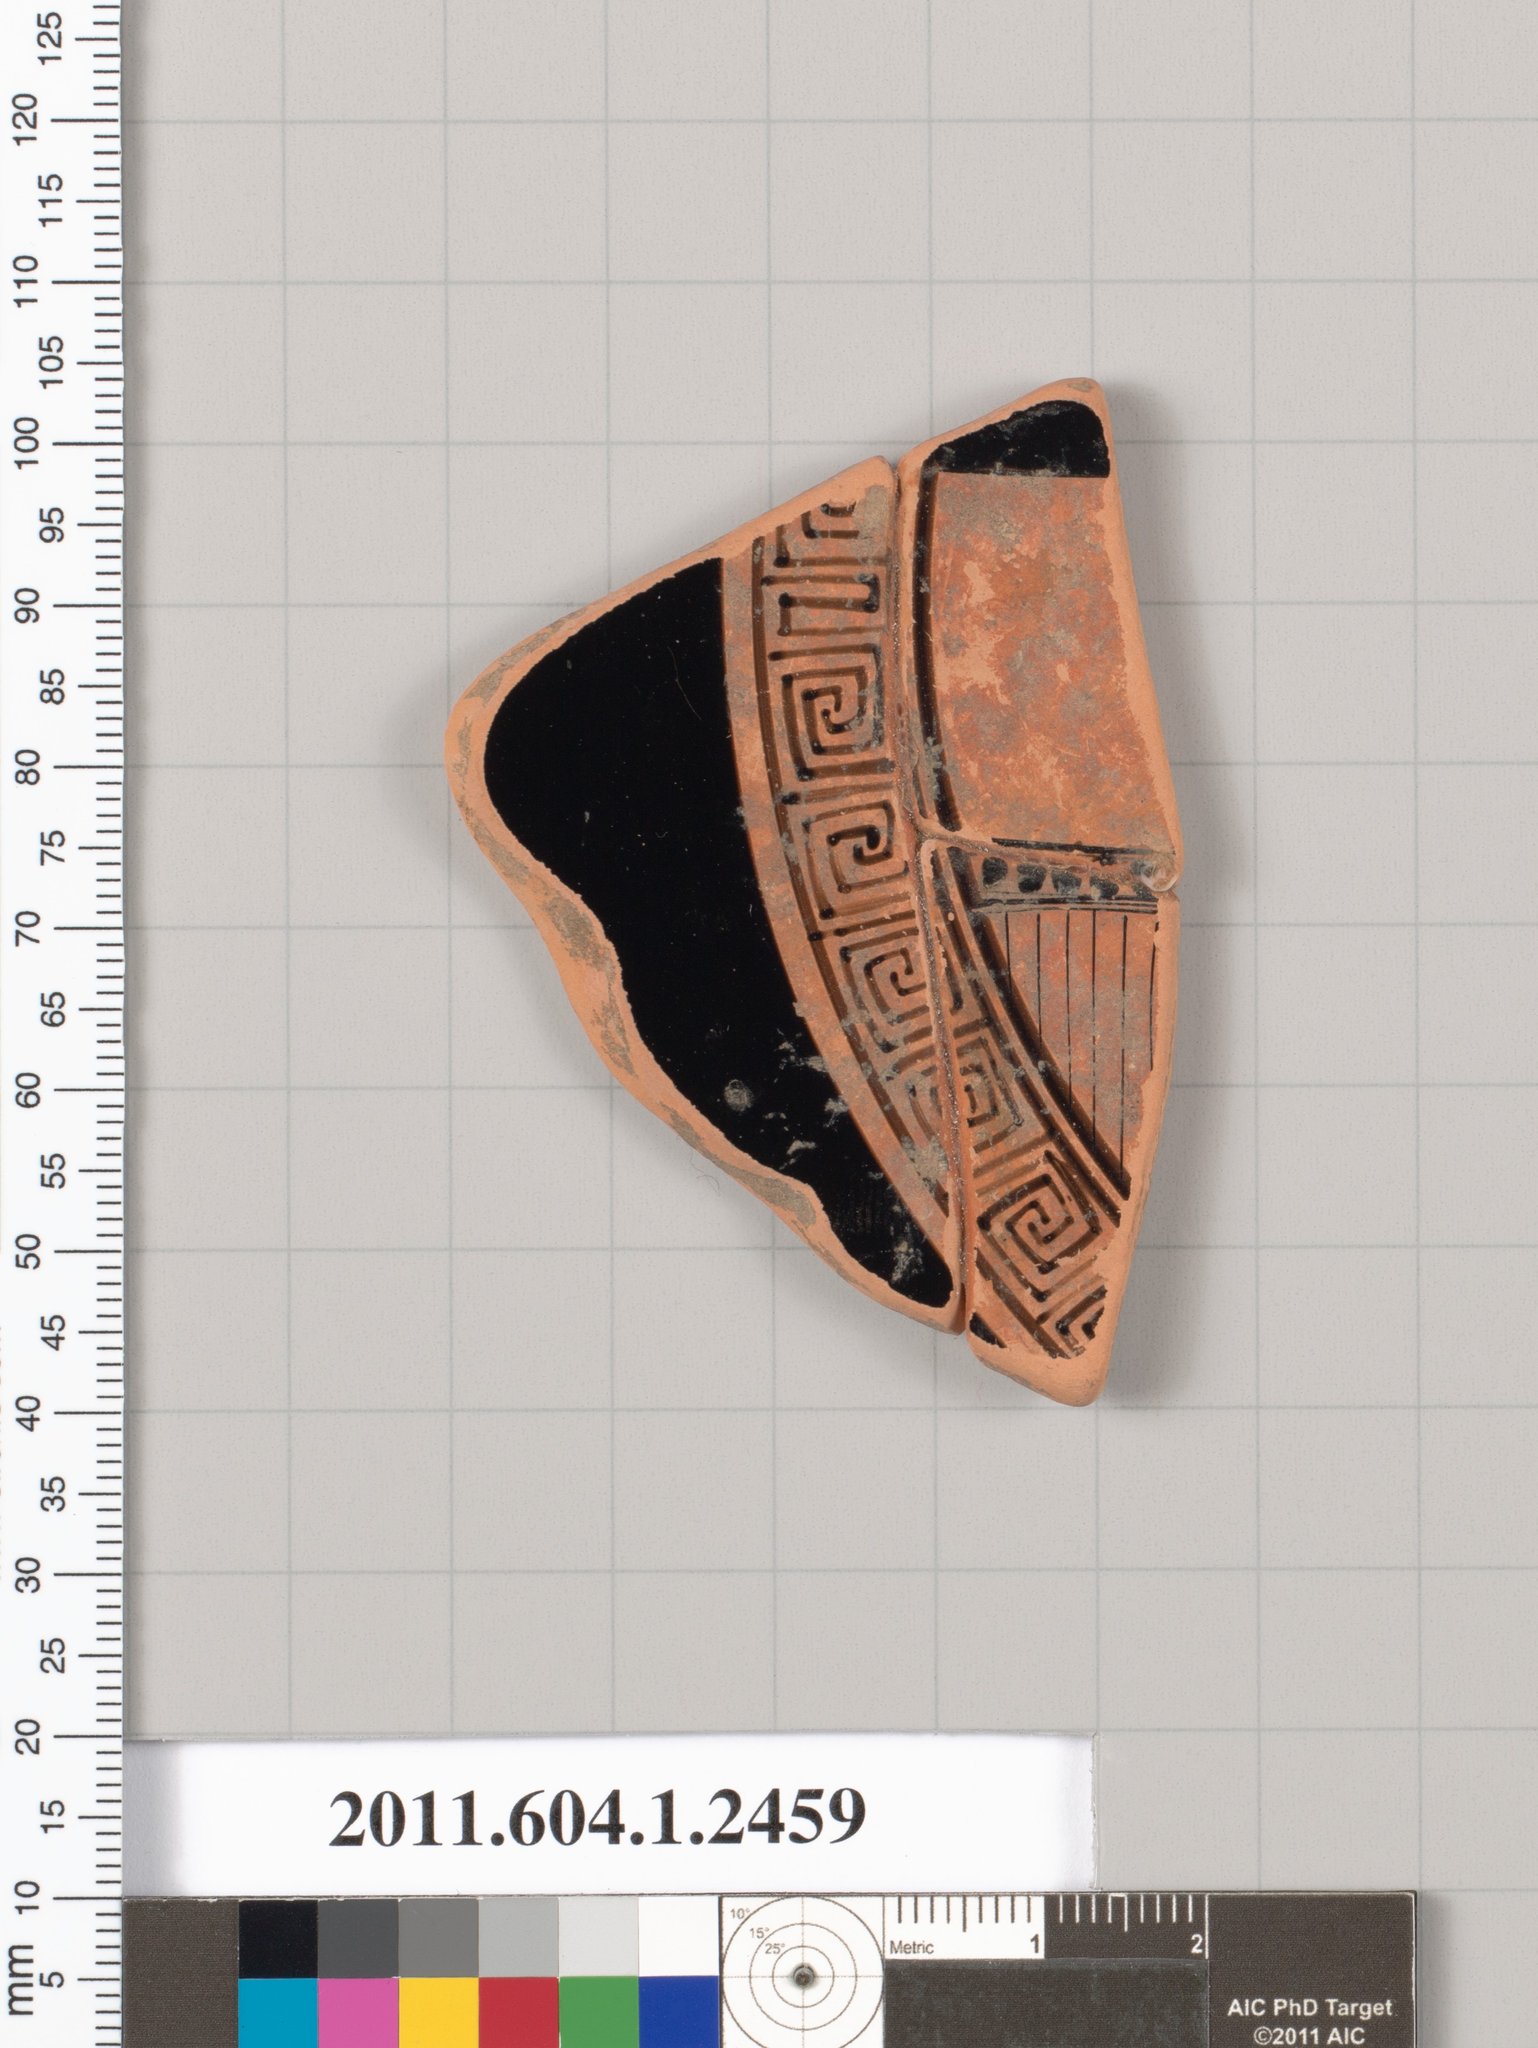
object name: kylix fragment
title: Terracotta fragment of a kylix (drinking cup)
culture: greek, attic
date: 490-480 BCE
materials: terracotta